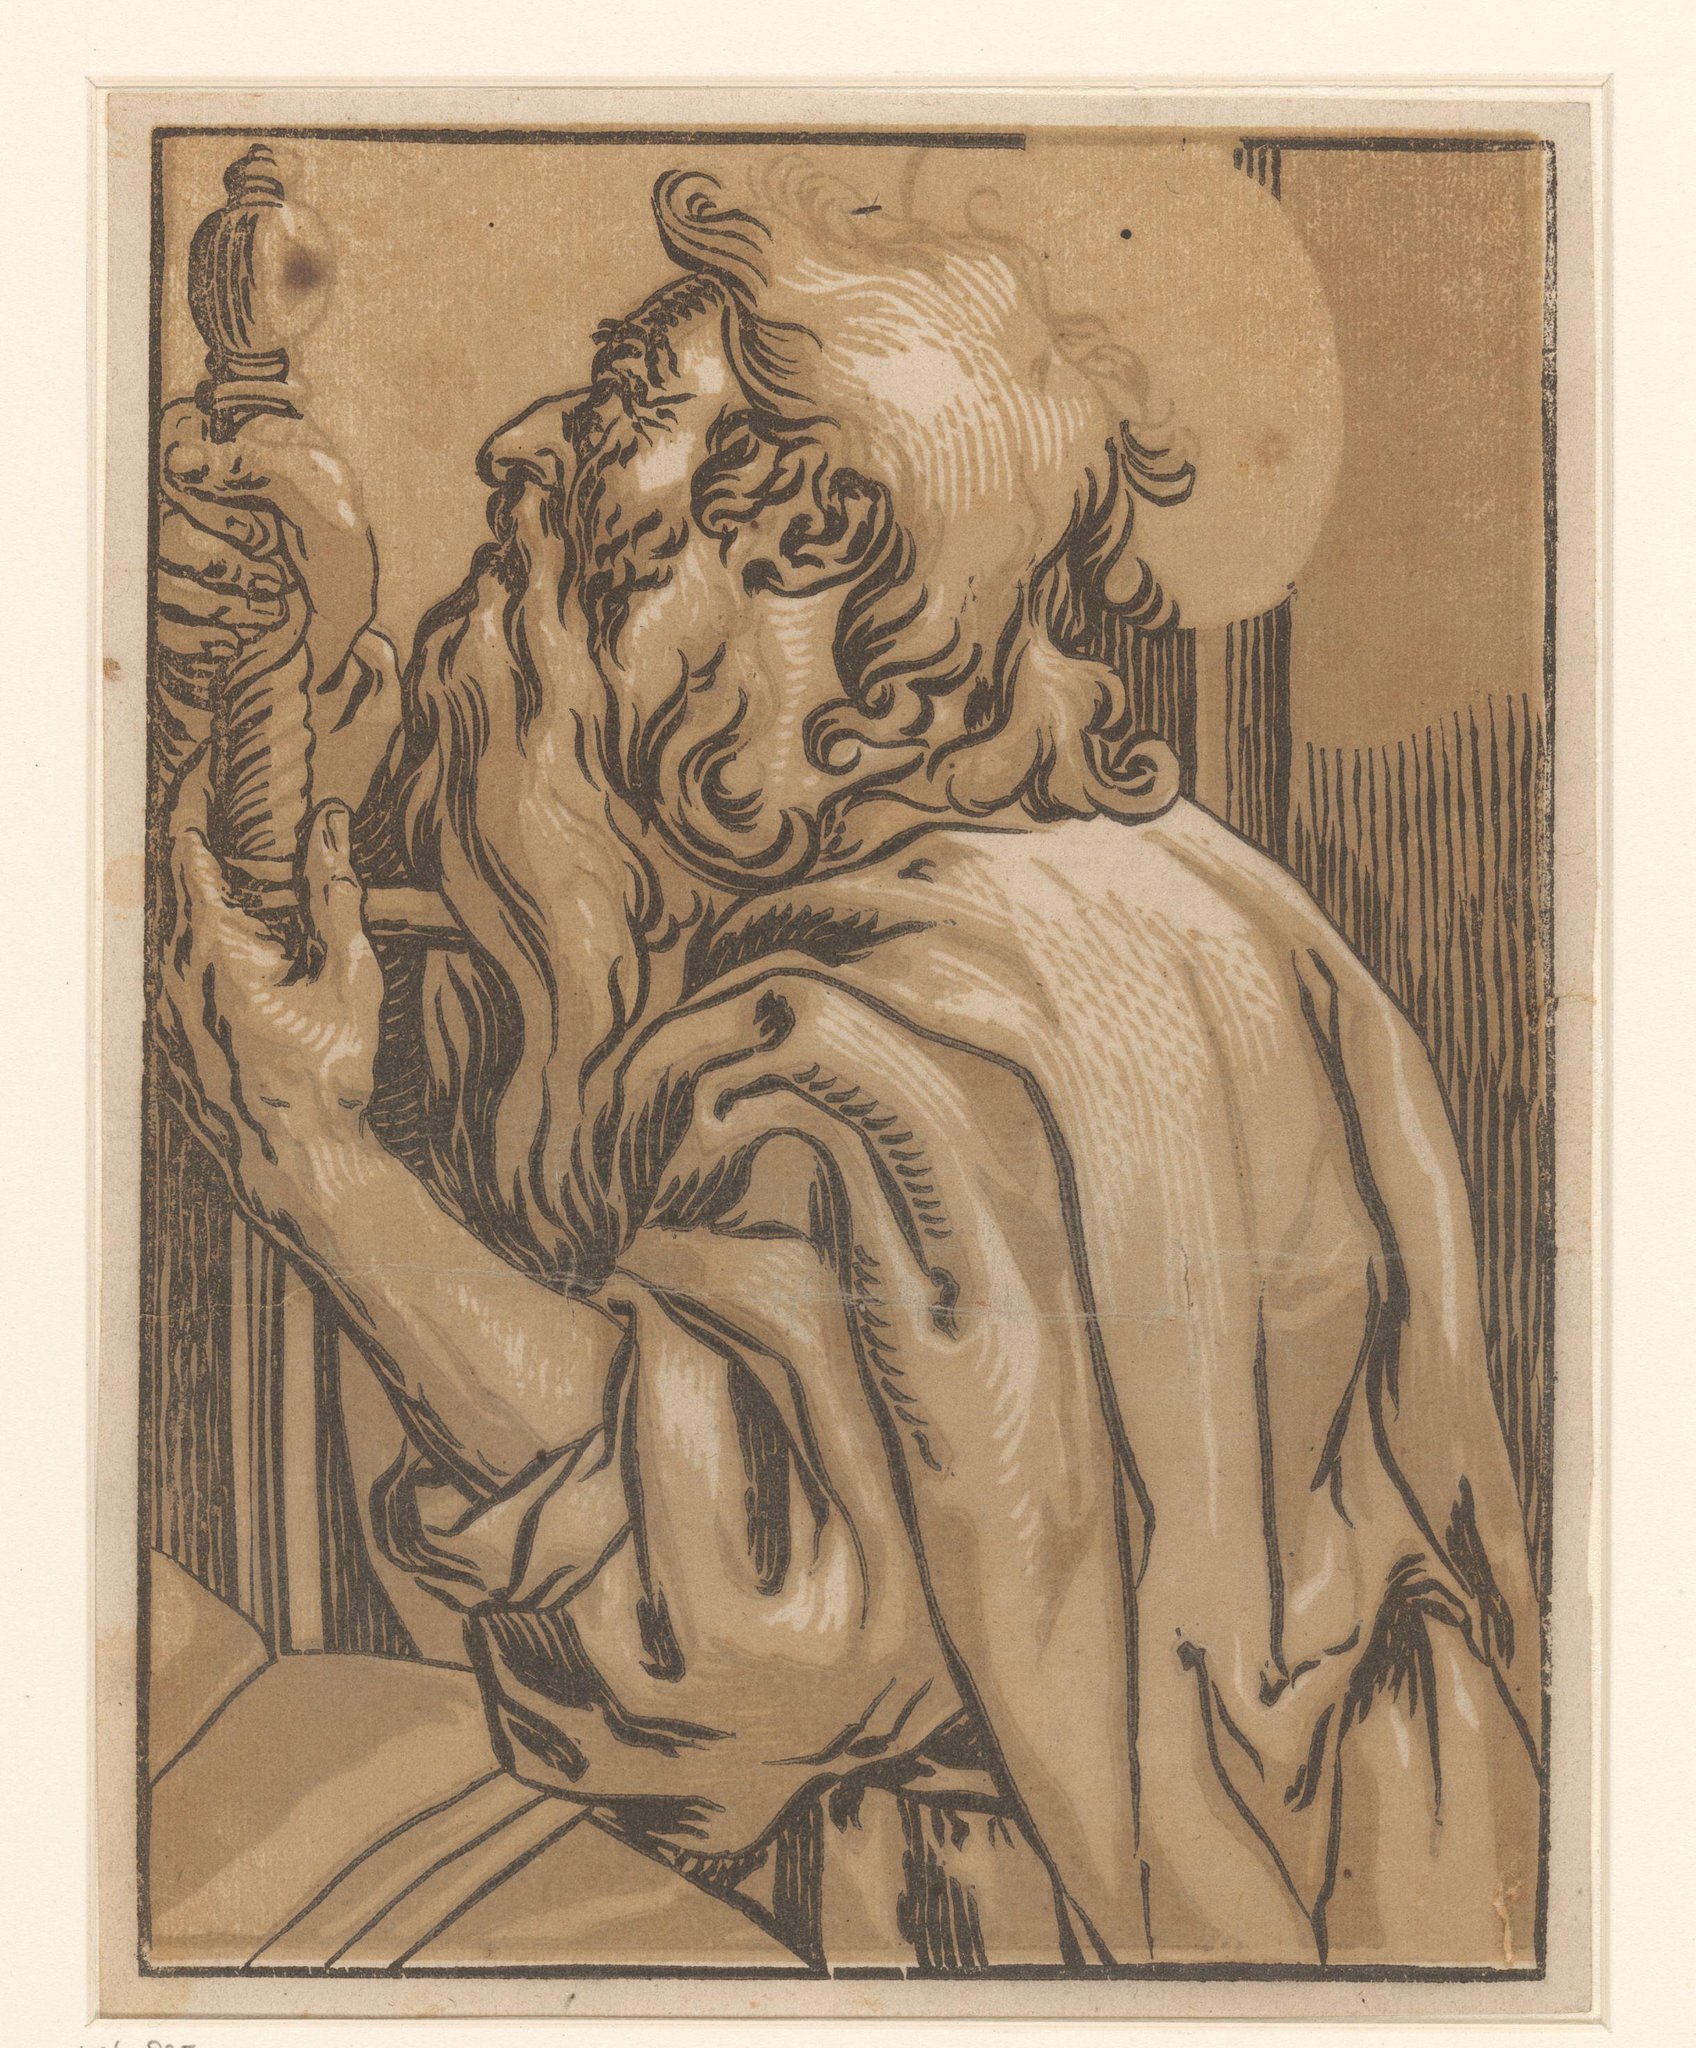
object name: print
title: Christus en de twaalf apostelen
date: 1600-1669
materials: paper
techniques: woodcut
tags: the apostle paul of tarsus; possible attributes: book, scroll, sword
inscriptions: collector's mark: Lugt 2228